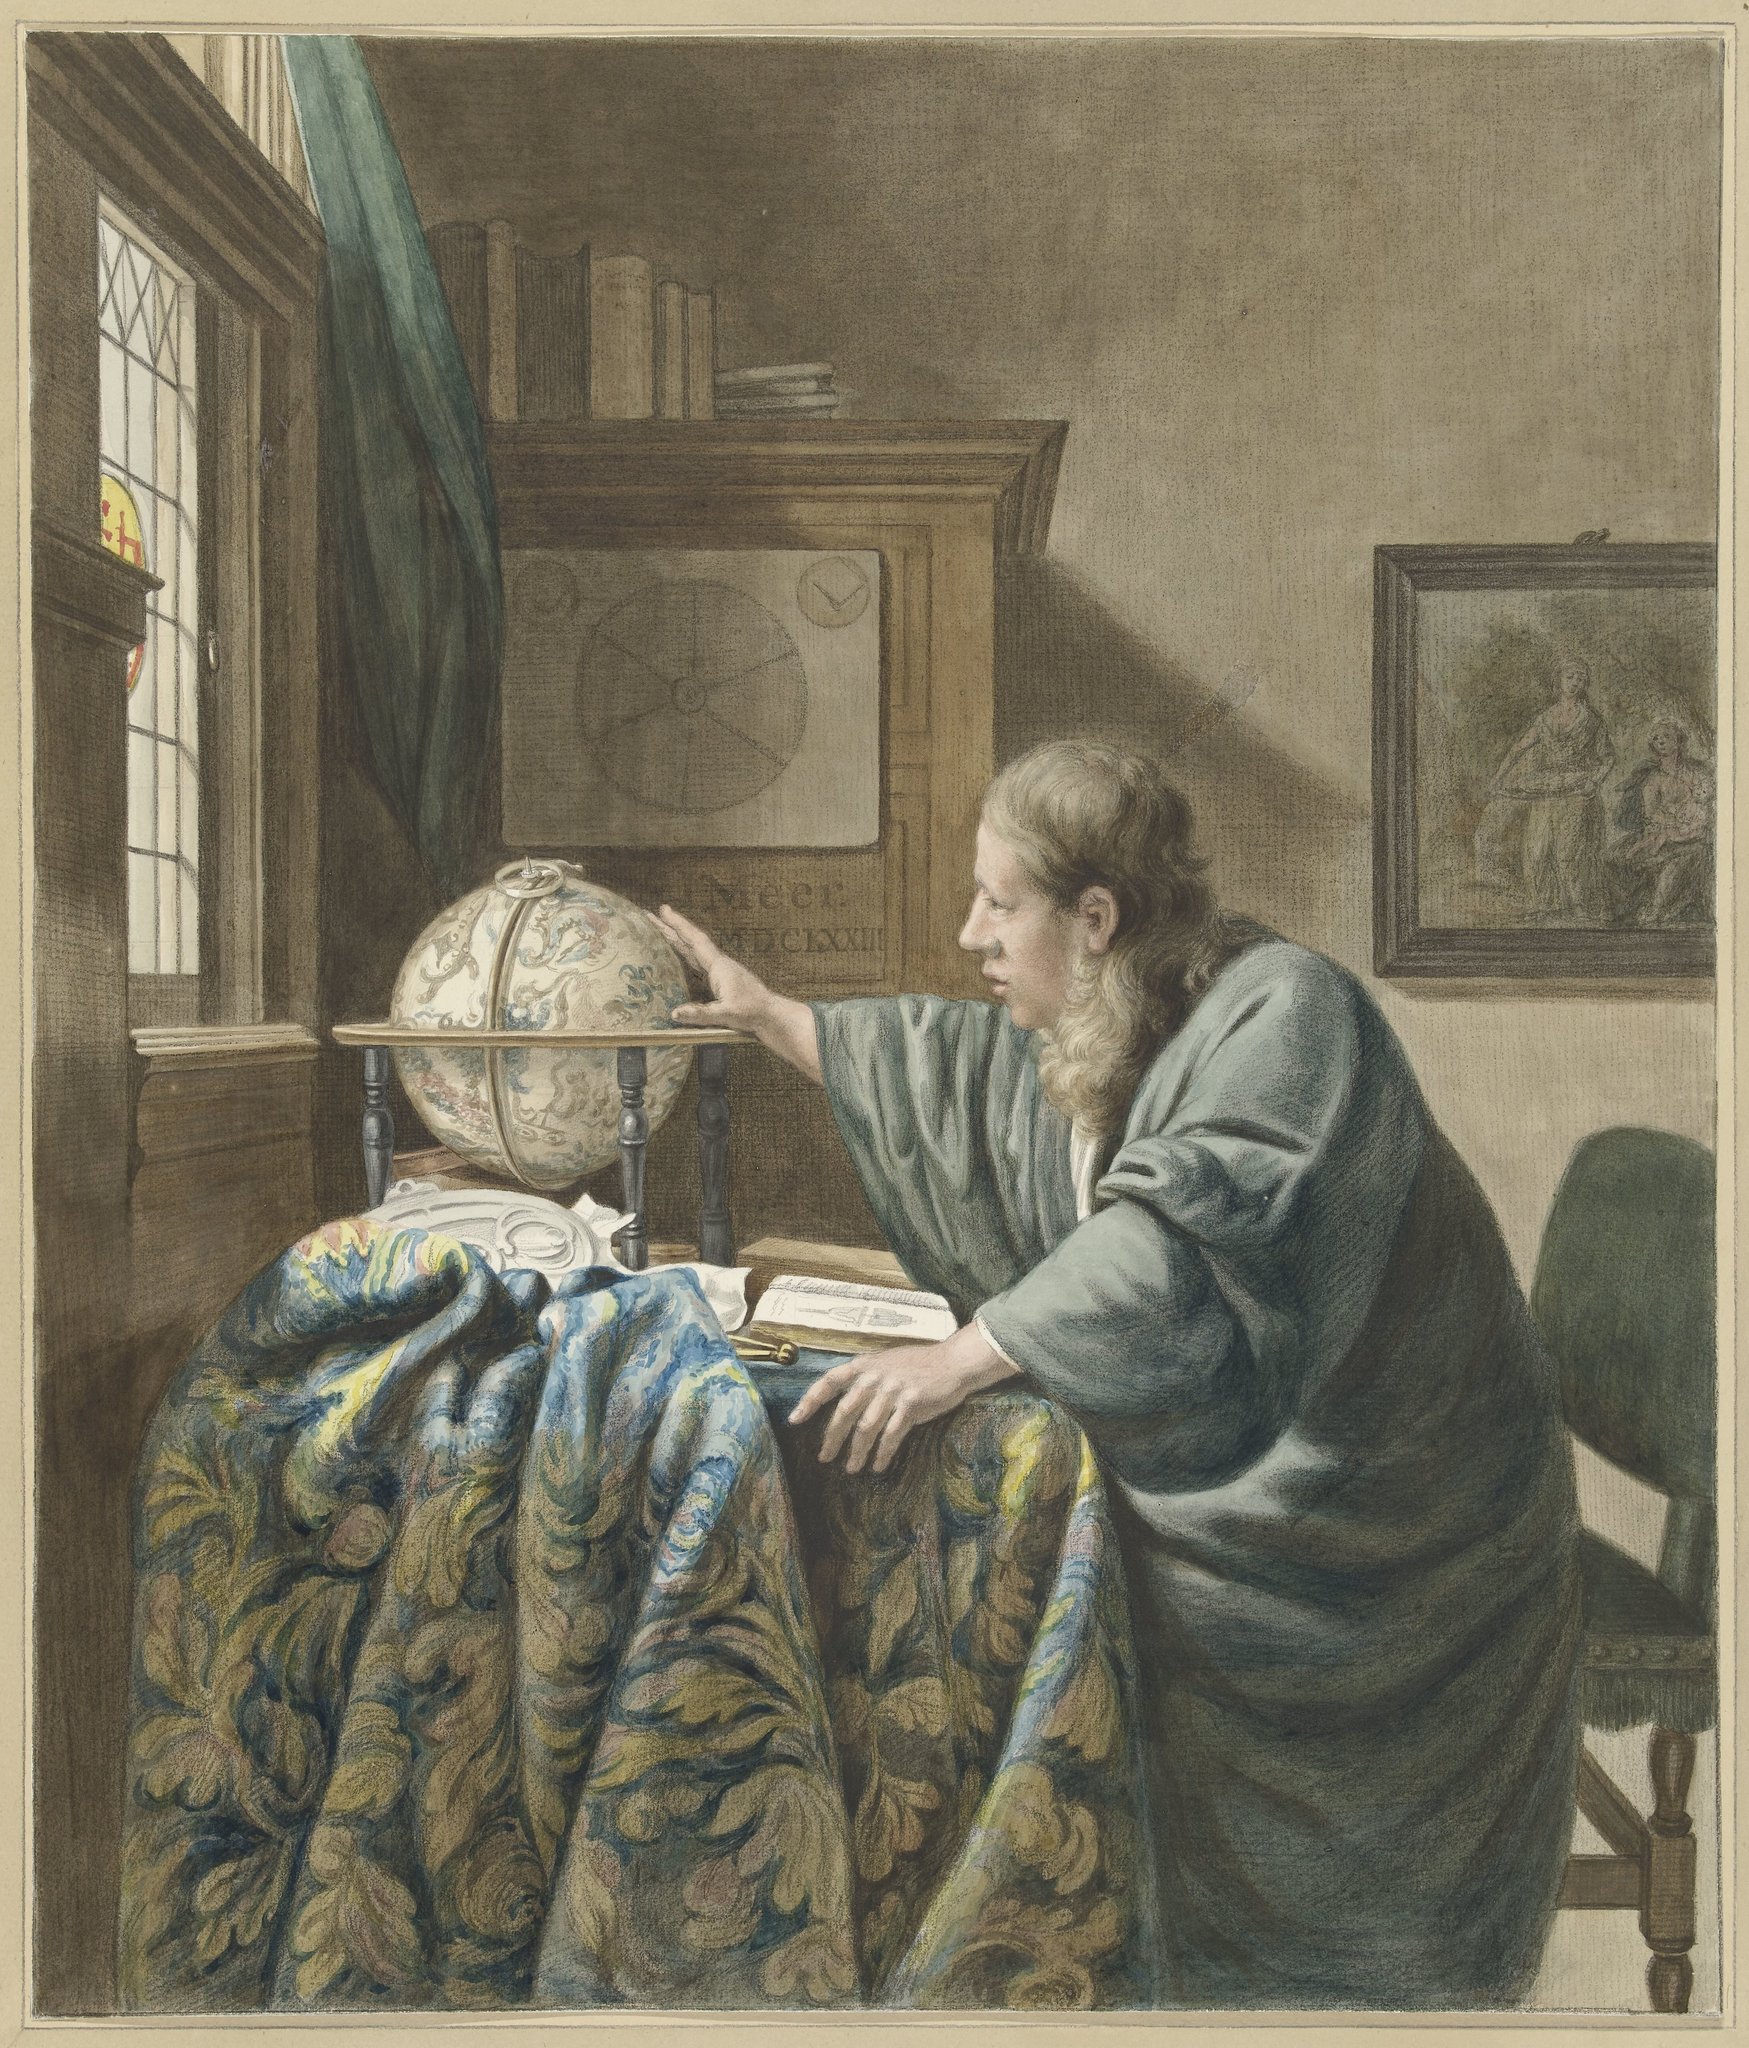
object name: drawing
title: De astronoom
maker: abraham delfos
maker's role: draughtsman, painter, print maker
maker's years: 1731-1820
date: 1794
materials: chalk, paper, watercolor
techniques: brush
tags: scholar in his study, astronomy (and cosmography) (+ scholar, scientist (at work)), star-globe